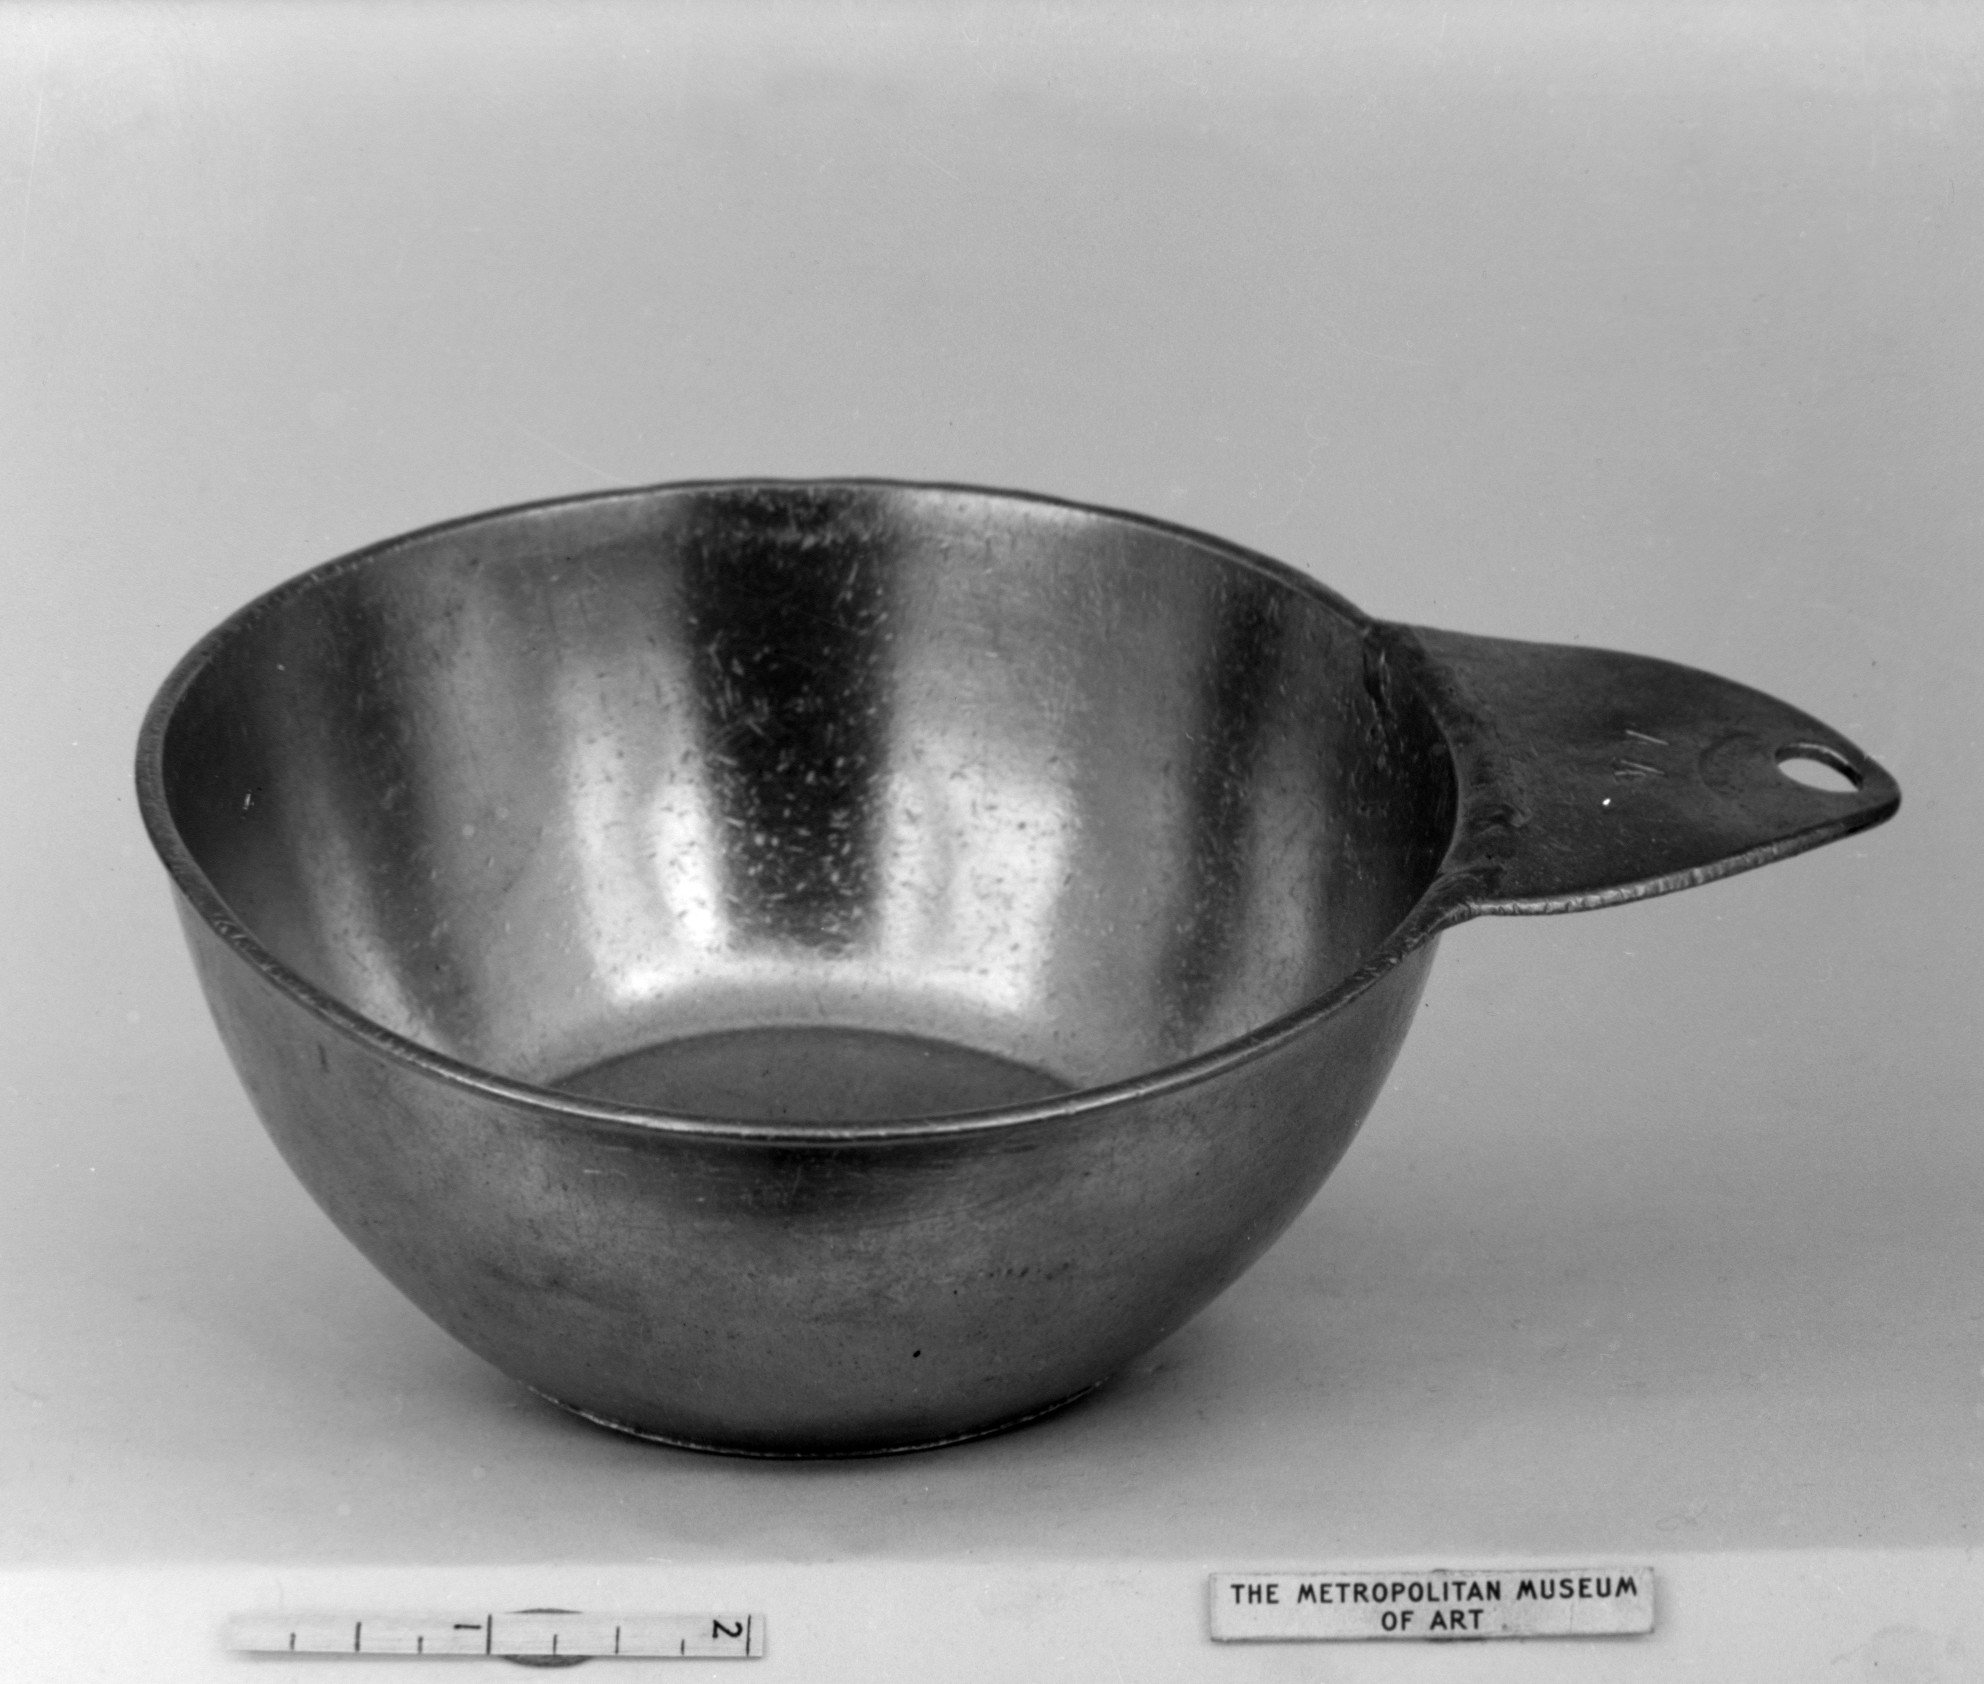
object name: broth bowl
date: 1601-1700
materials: pewter